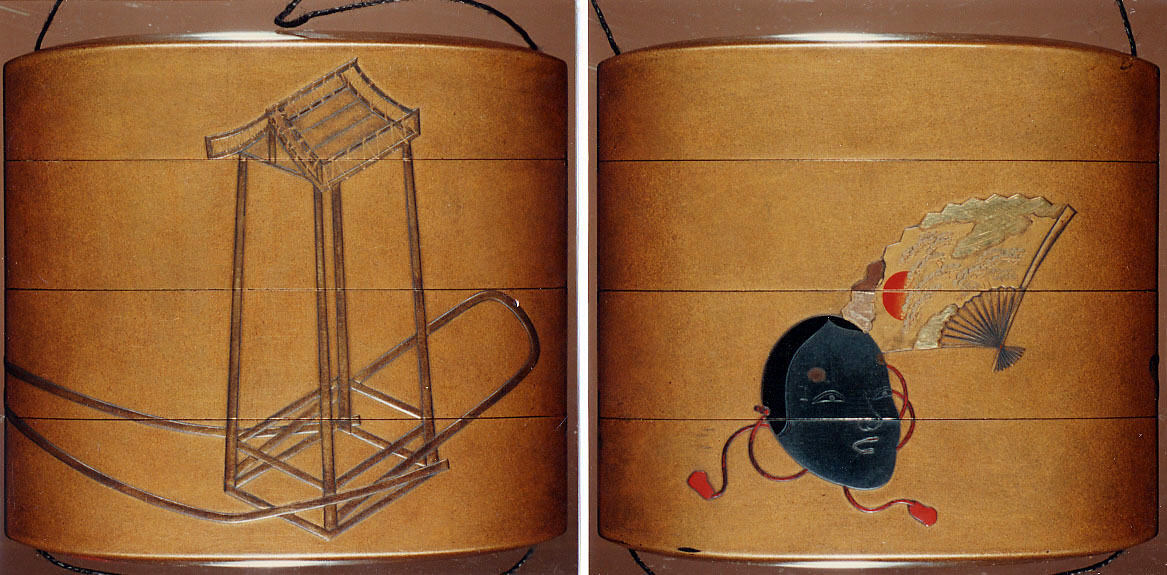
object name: inrō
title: Case (Inrō) with Design of Noh Mask with Red Sun above Pine Trees (obverse); Props for a Noh Play (reverse)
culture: japanese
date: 1801-1900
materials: foil, gold, lacquer, silver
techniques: fundame, hiramakie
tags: masks,fans